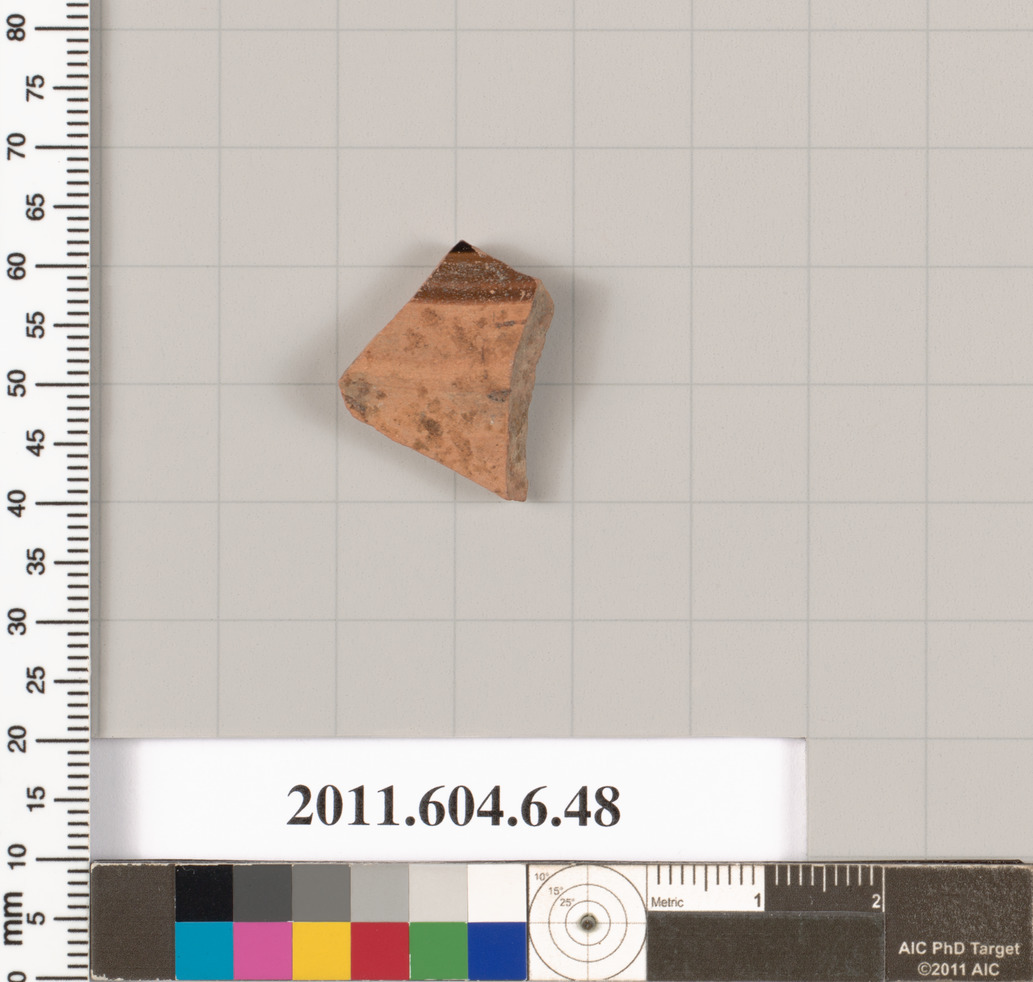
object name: undetermined shape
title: Terracotta fragment of an undetermined shape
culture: greek, attic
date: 600-401 BCE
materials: terracotta